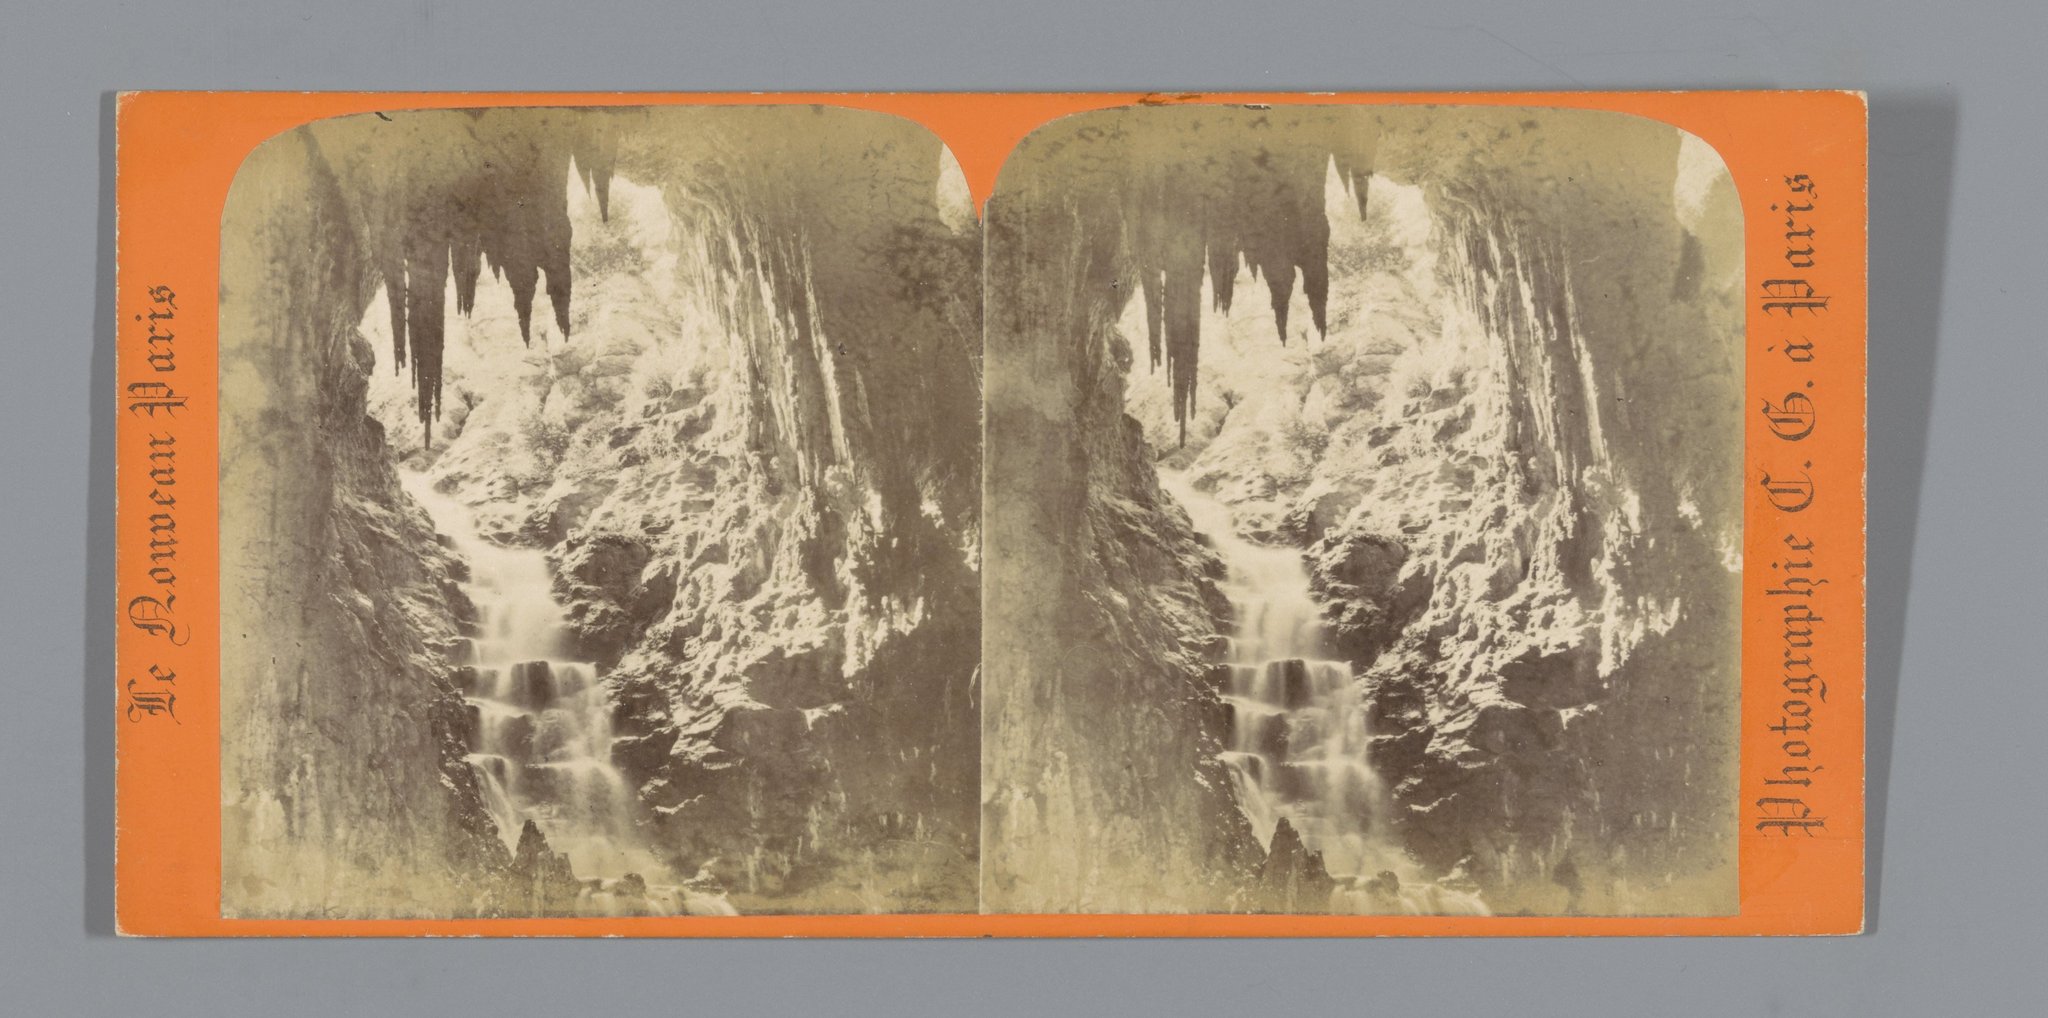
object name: stereograph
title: Le Nouveau Paris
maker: charles gérard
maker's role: fotograaf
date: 1860-1870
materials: cardboard, photographic support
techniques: albumen print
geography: parc des buttes-chaumont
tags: park, waterfall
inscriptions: inscription: ‘Cascade des buttes Chaumont’, inscription: ‘Photographie C. G. à Paris.’